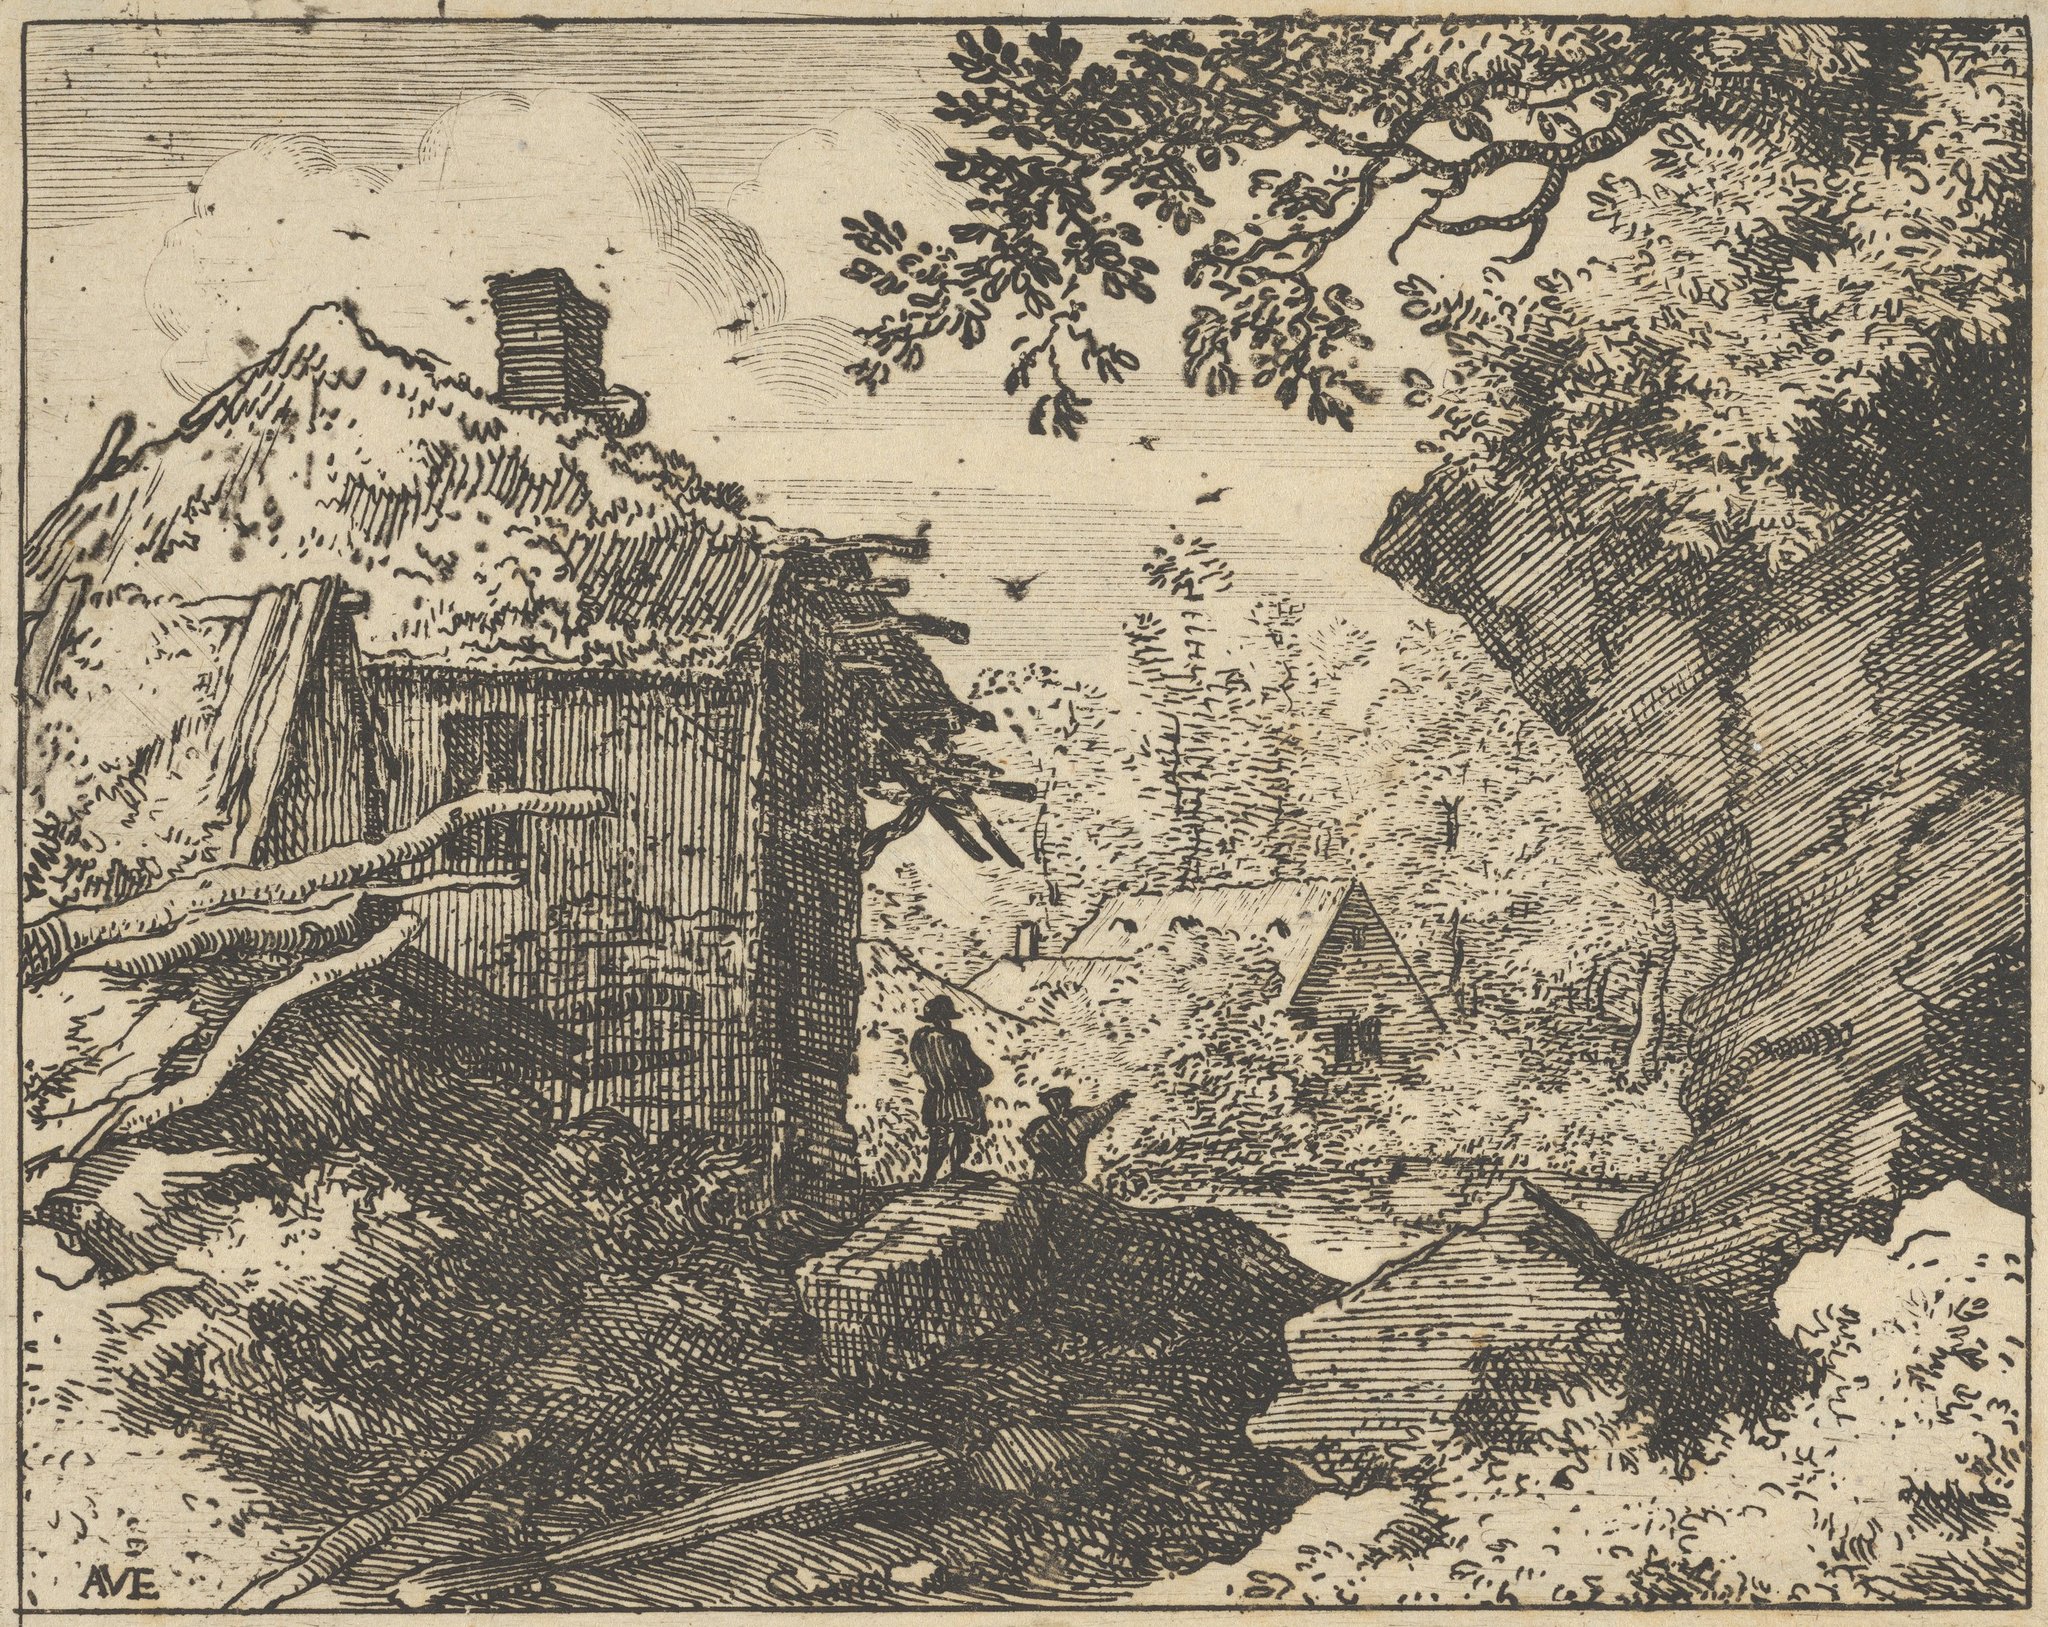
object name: print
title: The Straw Hut Seen from Behind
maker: allart van everdingen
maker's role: artist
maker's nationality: dutch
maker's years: 1621-1675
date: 1621-1675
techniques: engraving